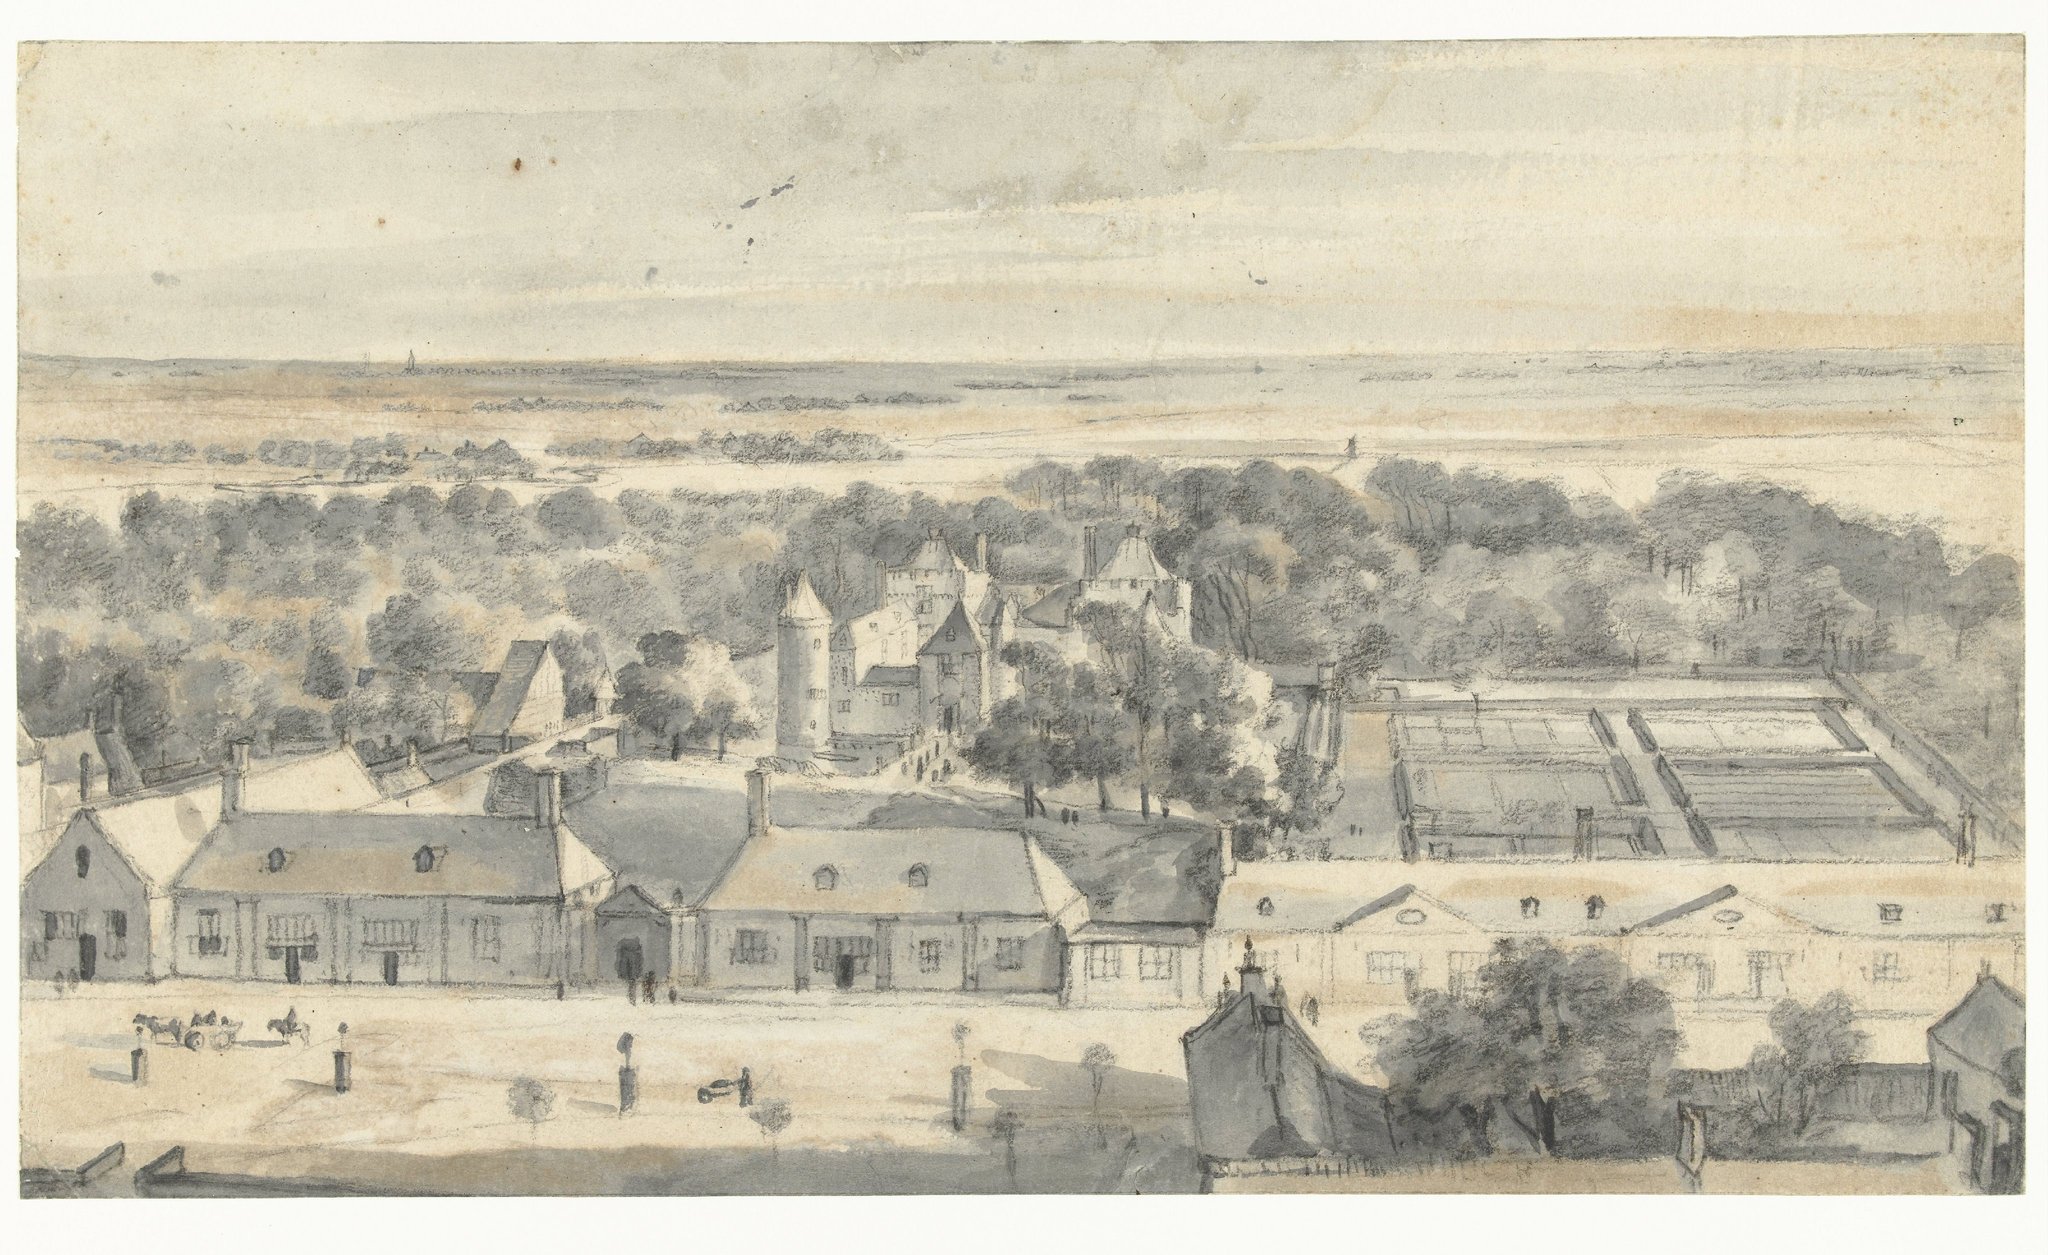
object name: drawing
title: Bird’s-eye View of Slot Schagen, Seen from the North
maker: roelant roghman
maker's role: draughtsman, painter, print maker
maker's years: 1627-1692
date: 1646-1647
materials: chalk, paper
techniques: brush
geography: schagen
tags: castle, bird's eye view ~ representation of building